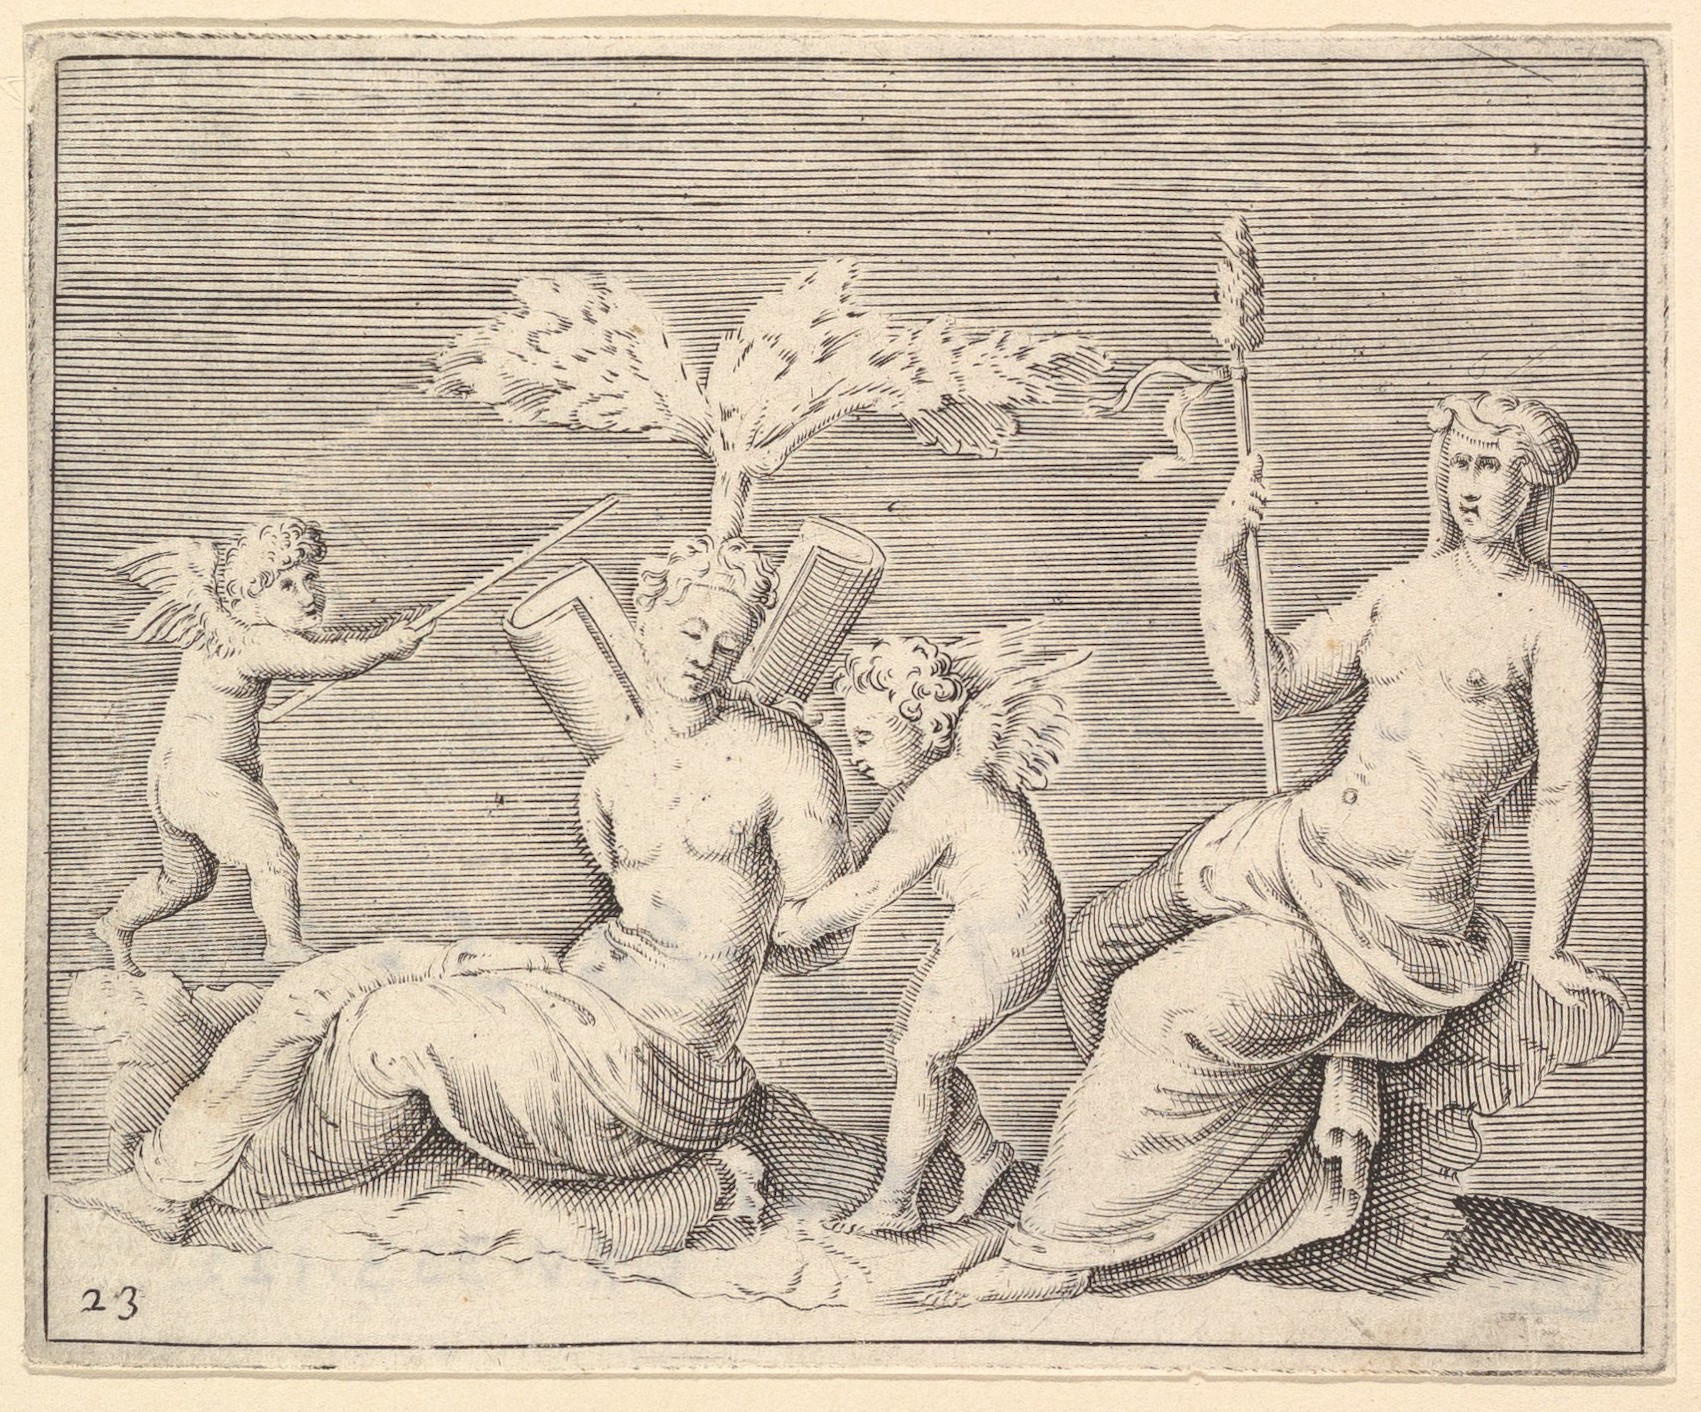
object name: print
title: Two Women and Two Cupids, from "Ex Antiquis Cameorum et Gemmae Delineata/ Liber Secundus/et ab Enea Vico Parmen Incis"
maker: anonymous, italian, 16th century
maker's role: artist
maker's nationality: italian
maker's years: 1500-1600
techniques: engraving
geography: rome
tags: female nudes,cupid